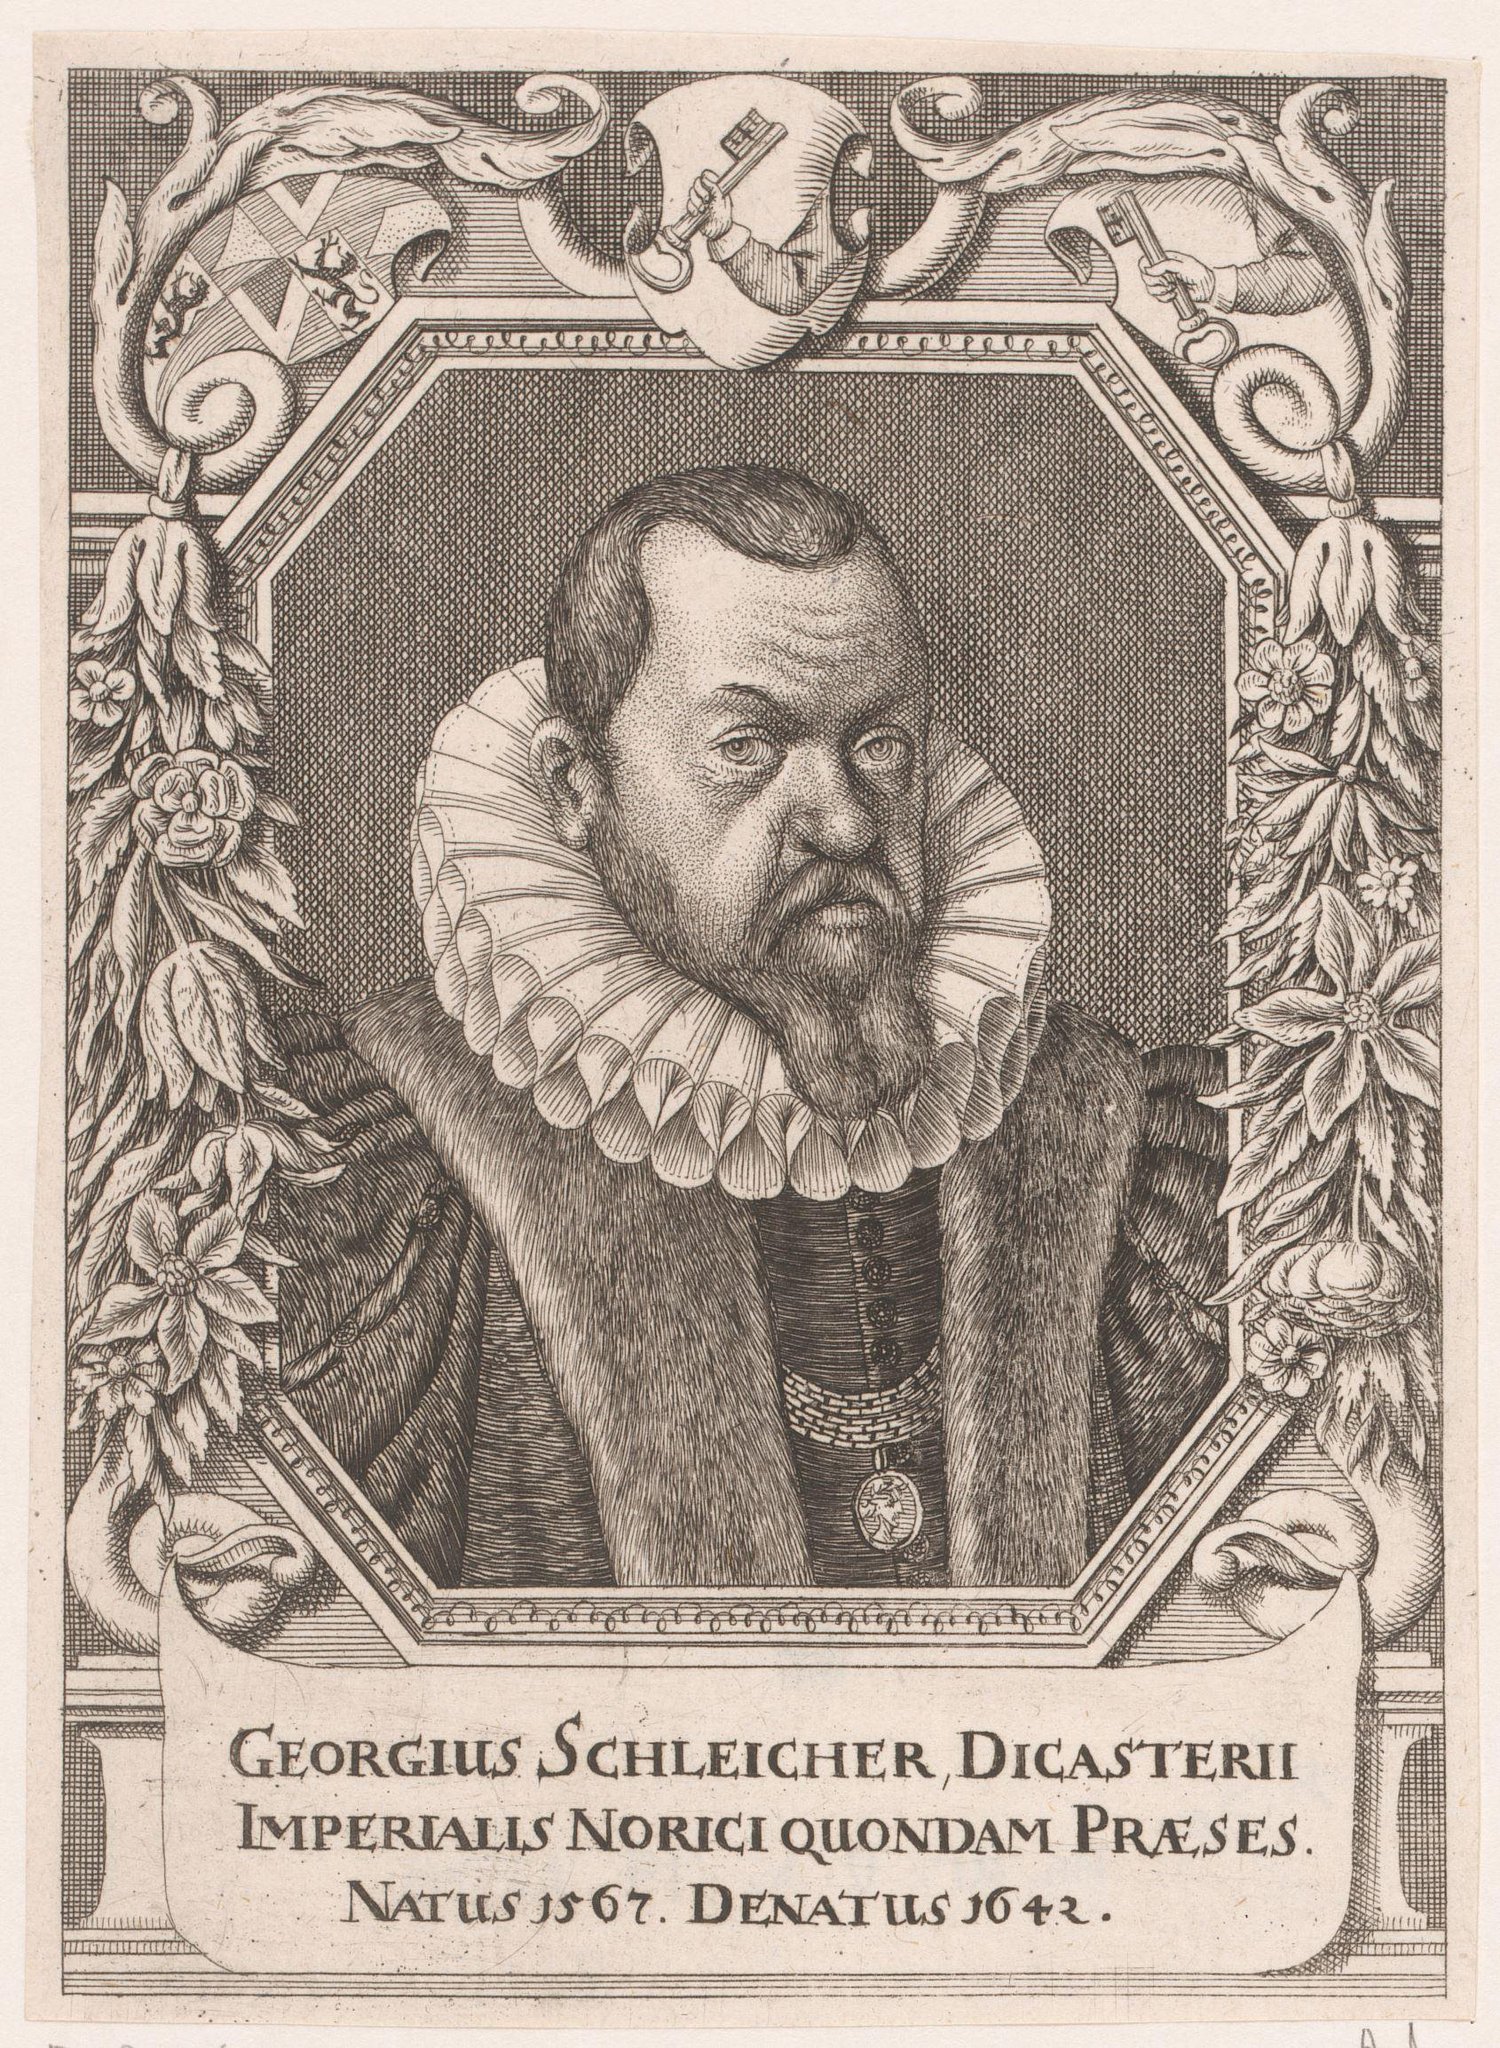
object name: print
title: Portret van Georg Schleicher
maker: johann carl von thill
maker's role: draughtsman, painter, print maker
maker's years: 1624-1676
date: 1642-1676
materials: paper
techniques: etching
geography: germany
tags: historical persons, armorial bearing, heraldry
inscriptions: collector's mark: Lugt 2228, collector's mark: Lugt 1337